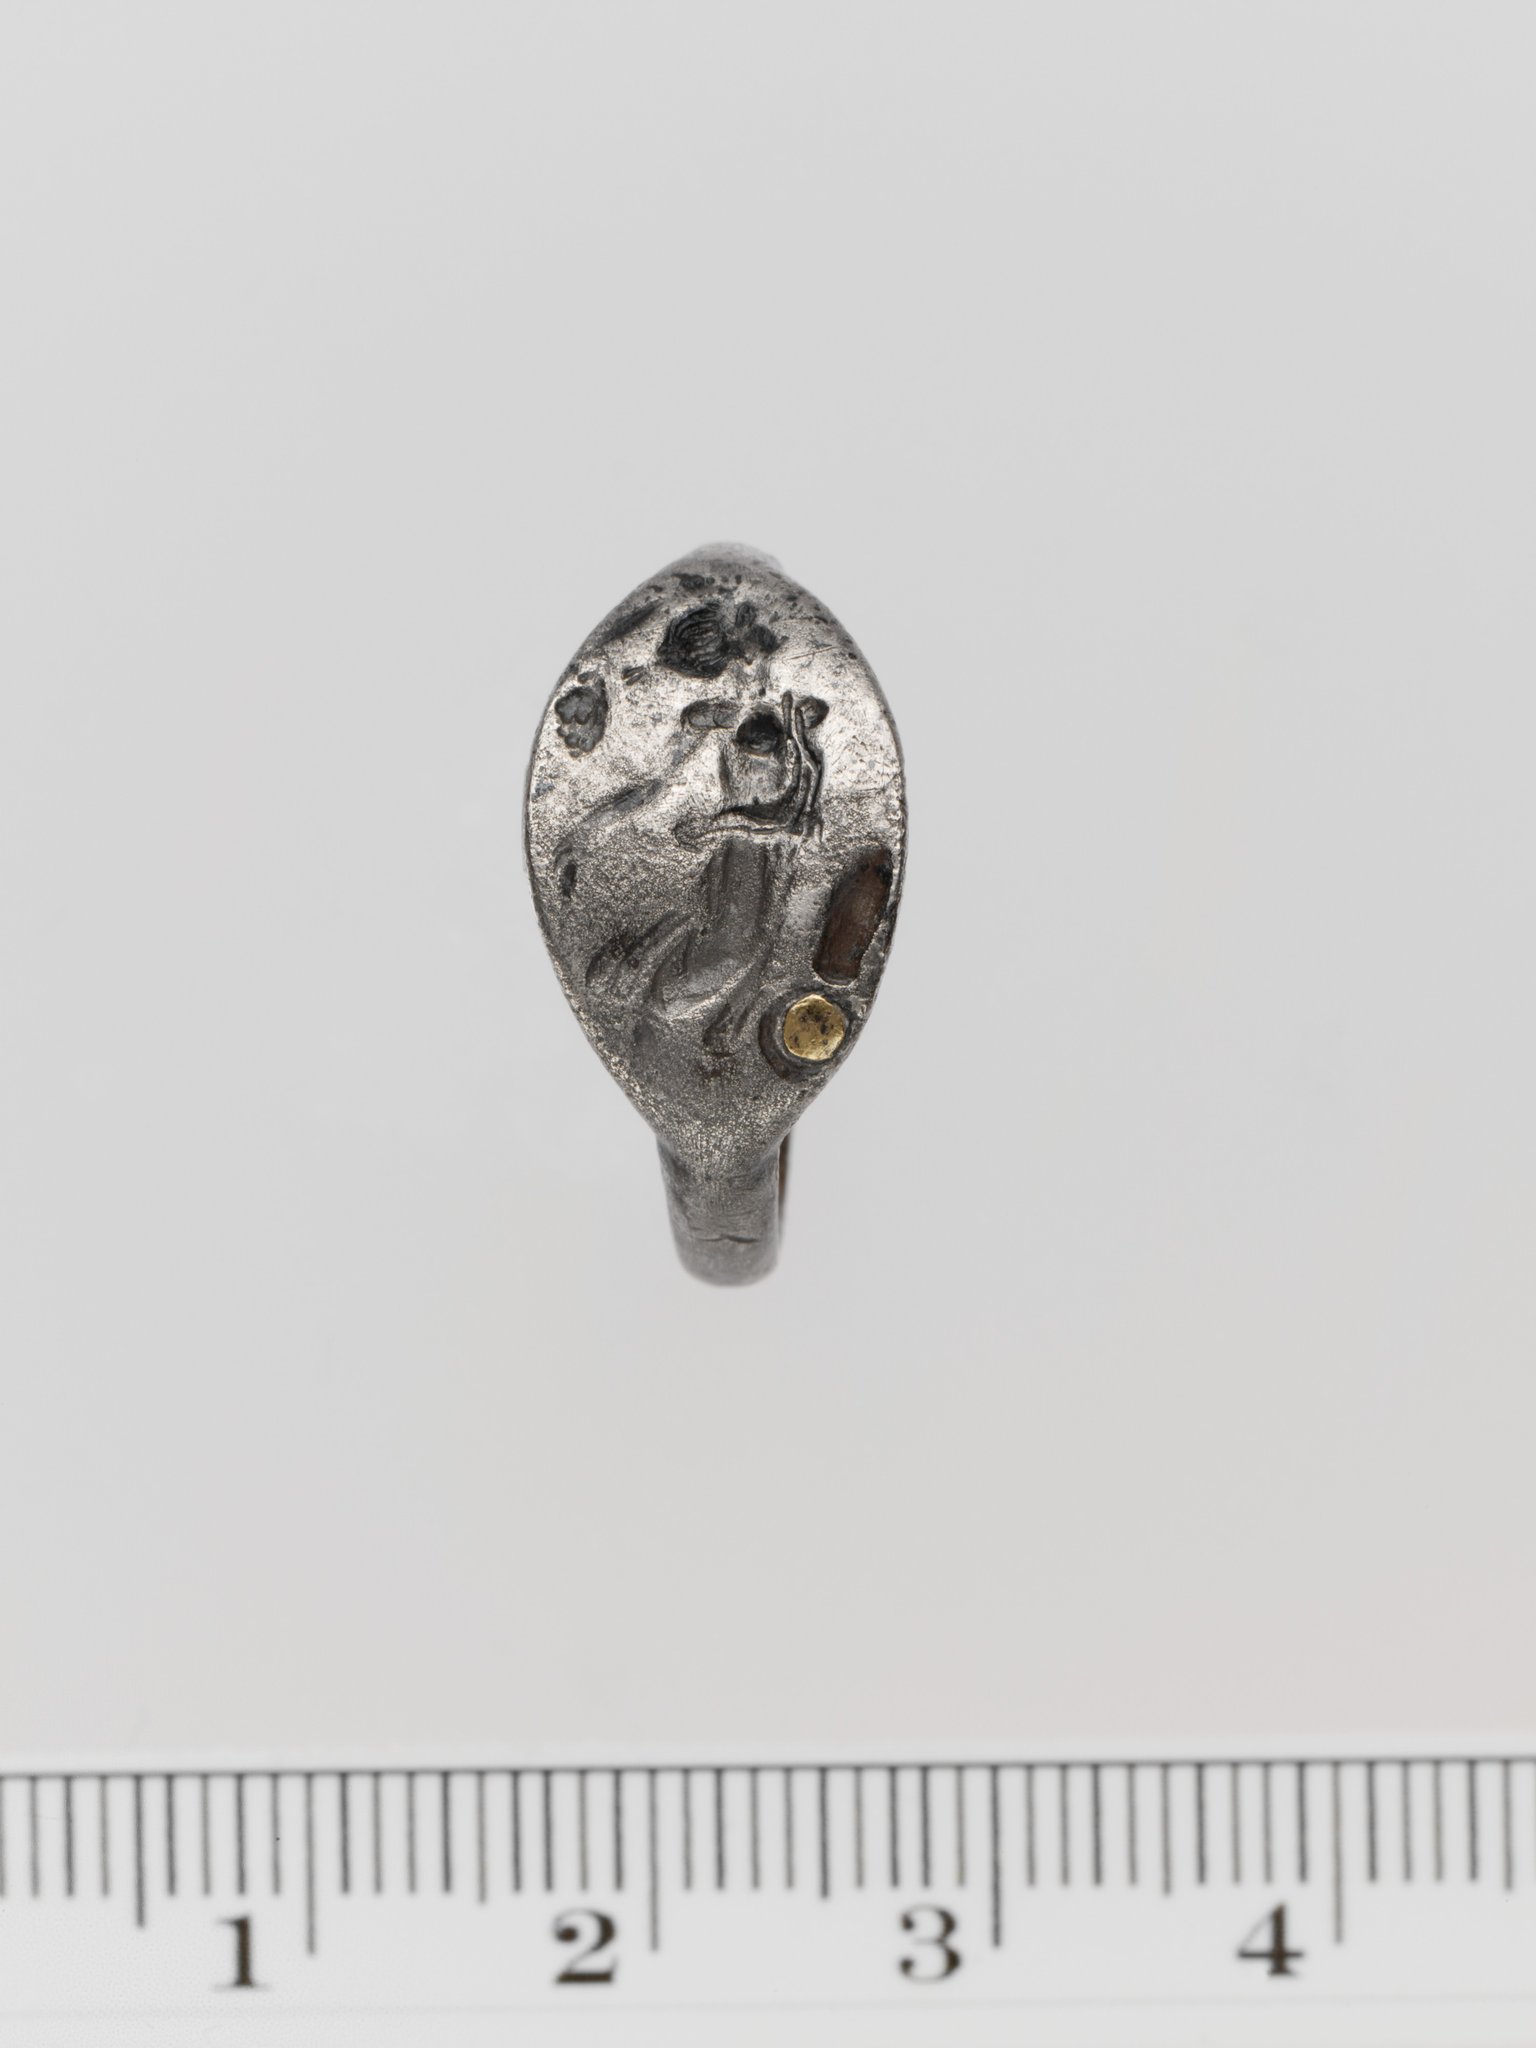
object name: ring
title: Silver ring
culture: greek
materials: silver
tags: dancing,maenads